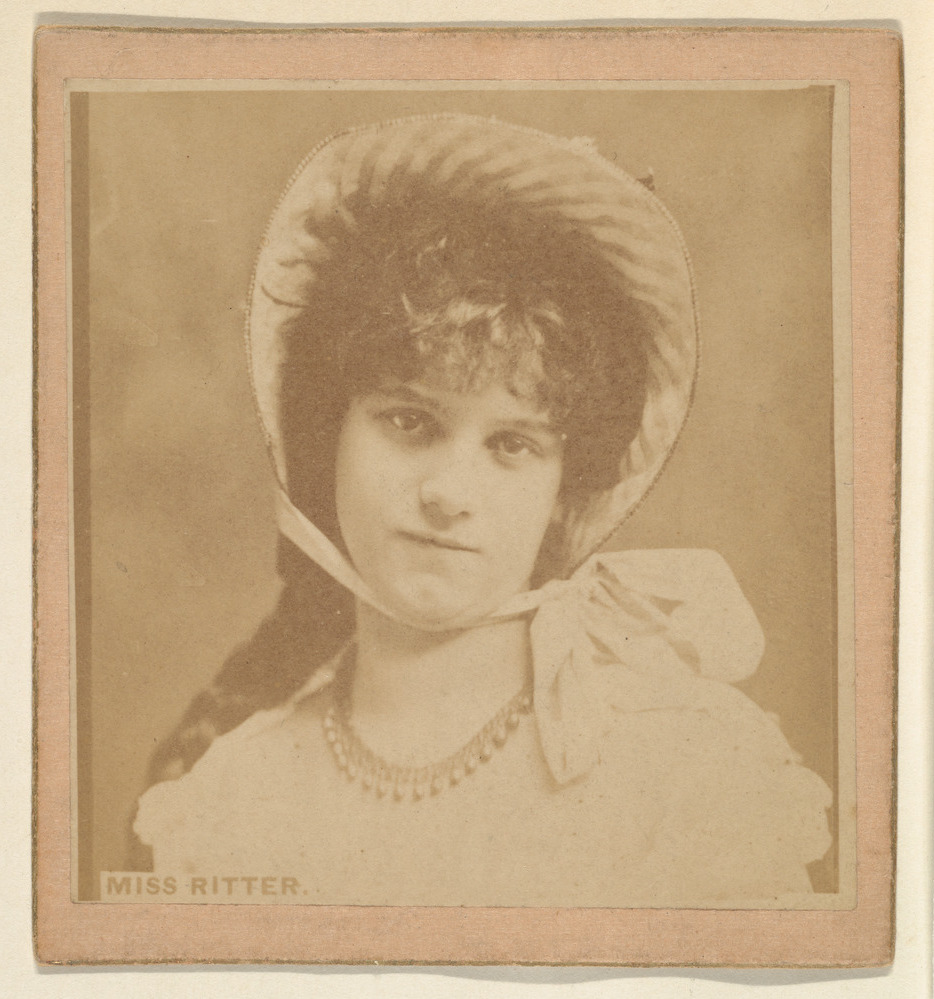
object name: photograph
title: Miss Ritter, from the Actresses series (N246), Type 2, issued by Kinney Brothers to promote Sporting Extra Cigarettes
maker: kinney brothers tobacco company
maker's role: publisher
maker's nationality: american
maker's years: 1869-2011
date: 1890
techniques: albumen silver print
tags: portraits,women,actresses